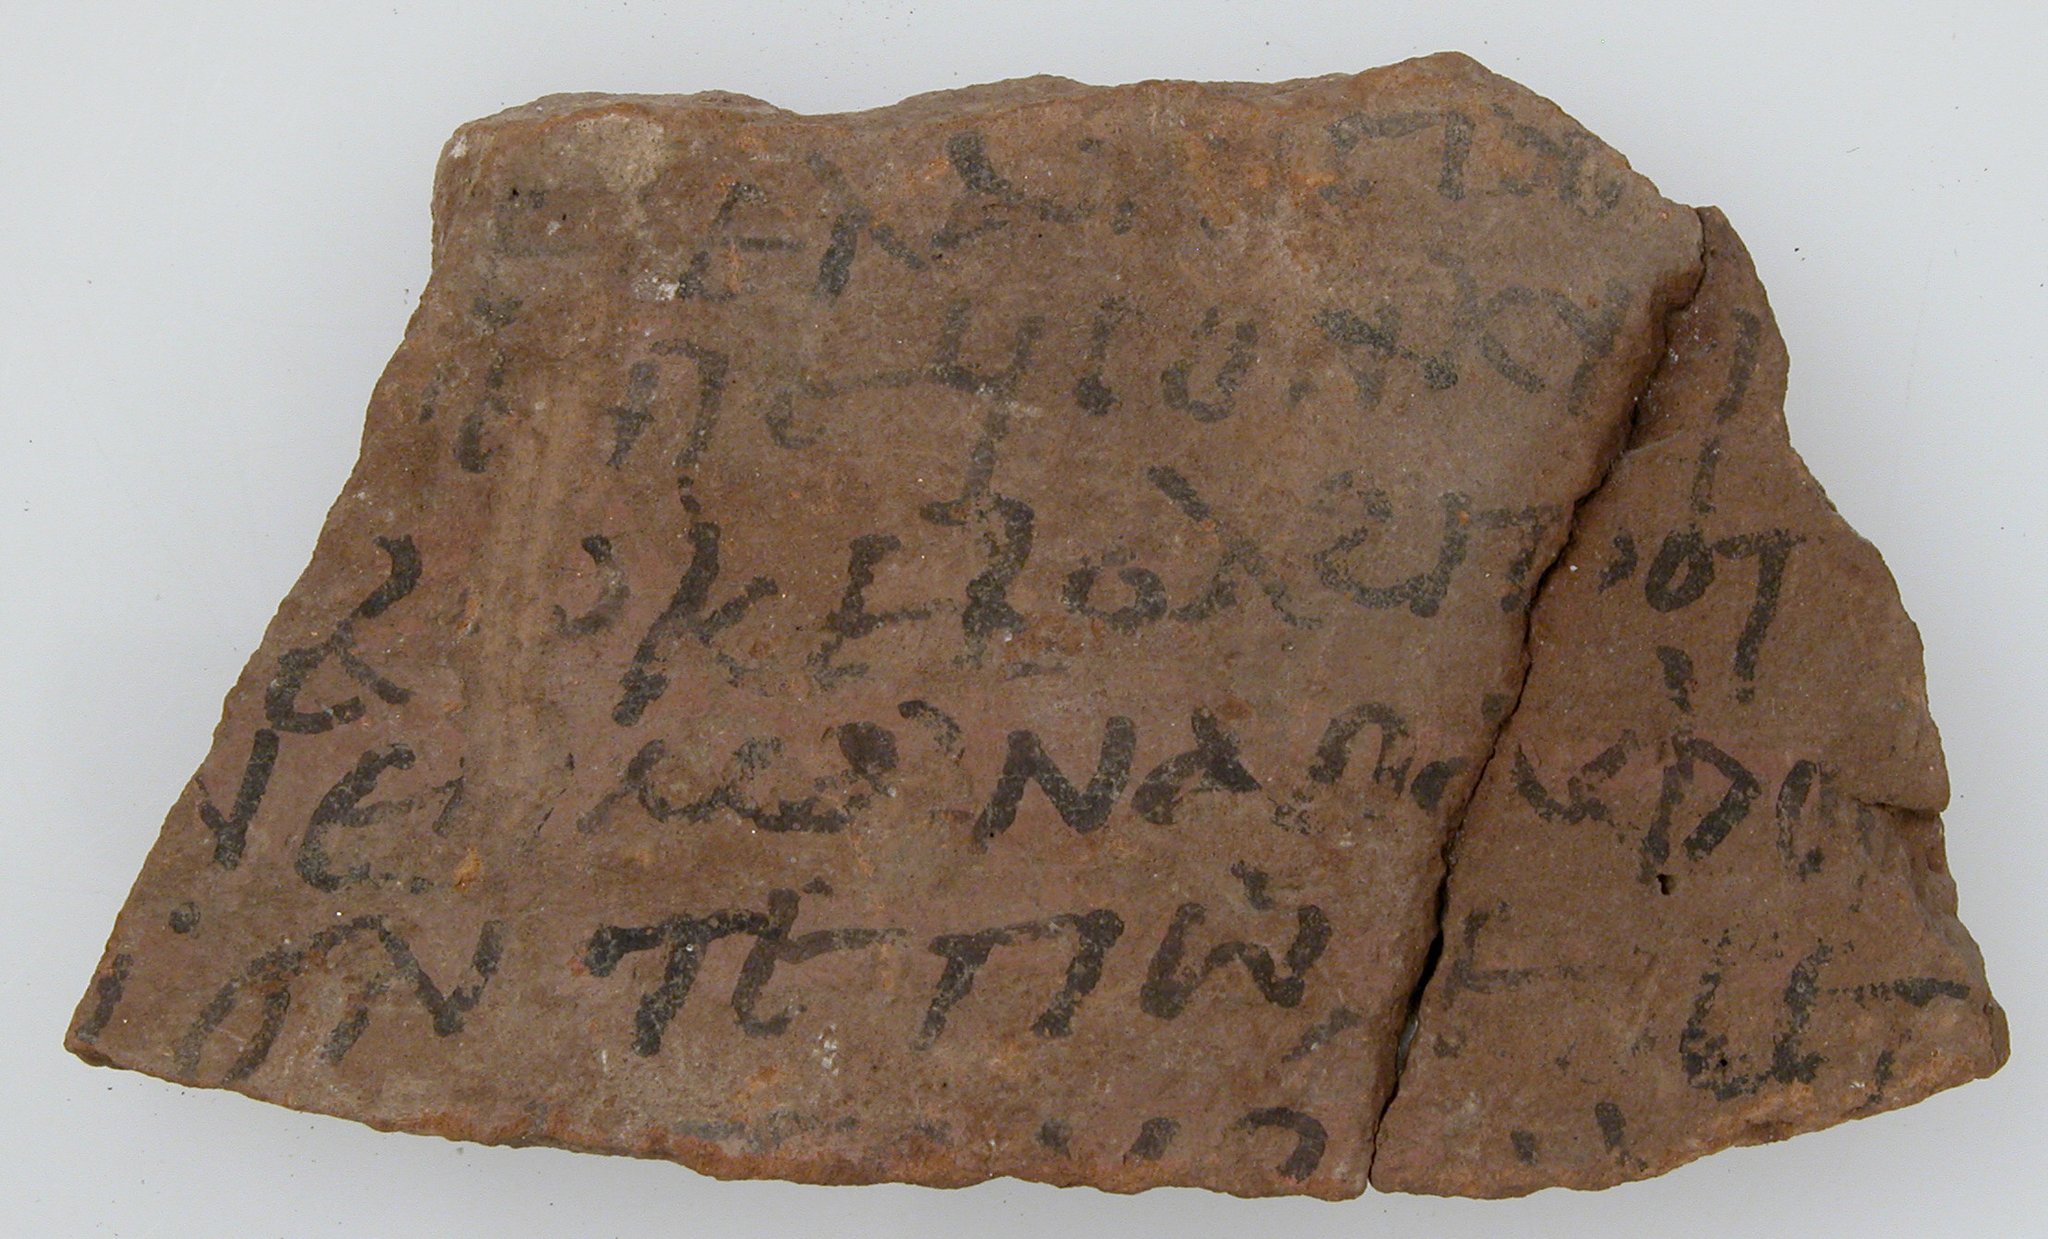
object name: ostrakon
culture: coptic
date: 600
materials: ink, pottery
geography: egypt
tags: coptic,documents